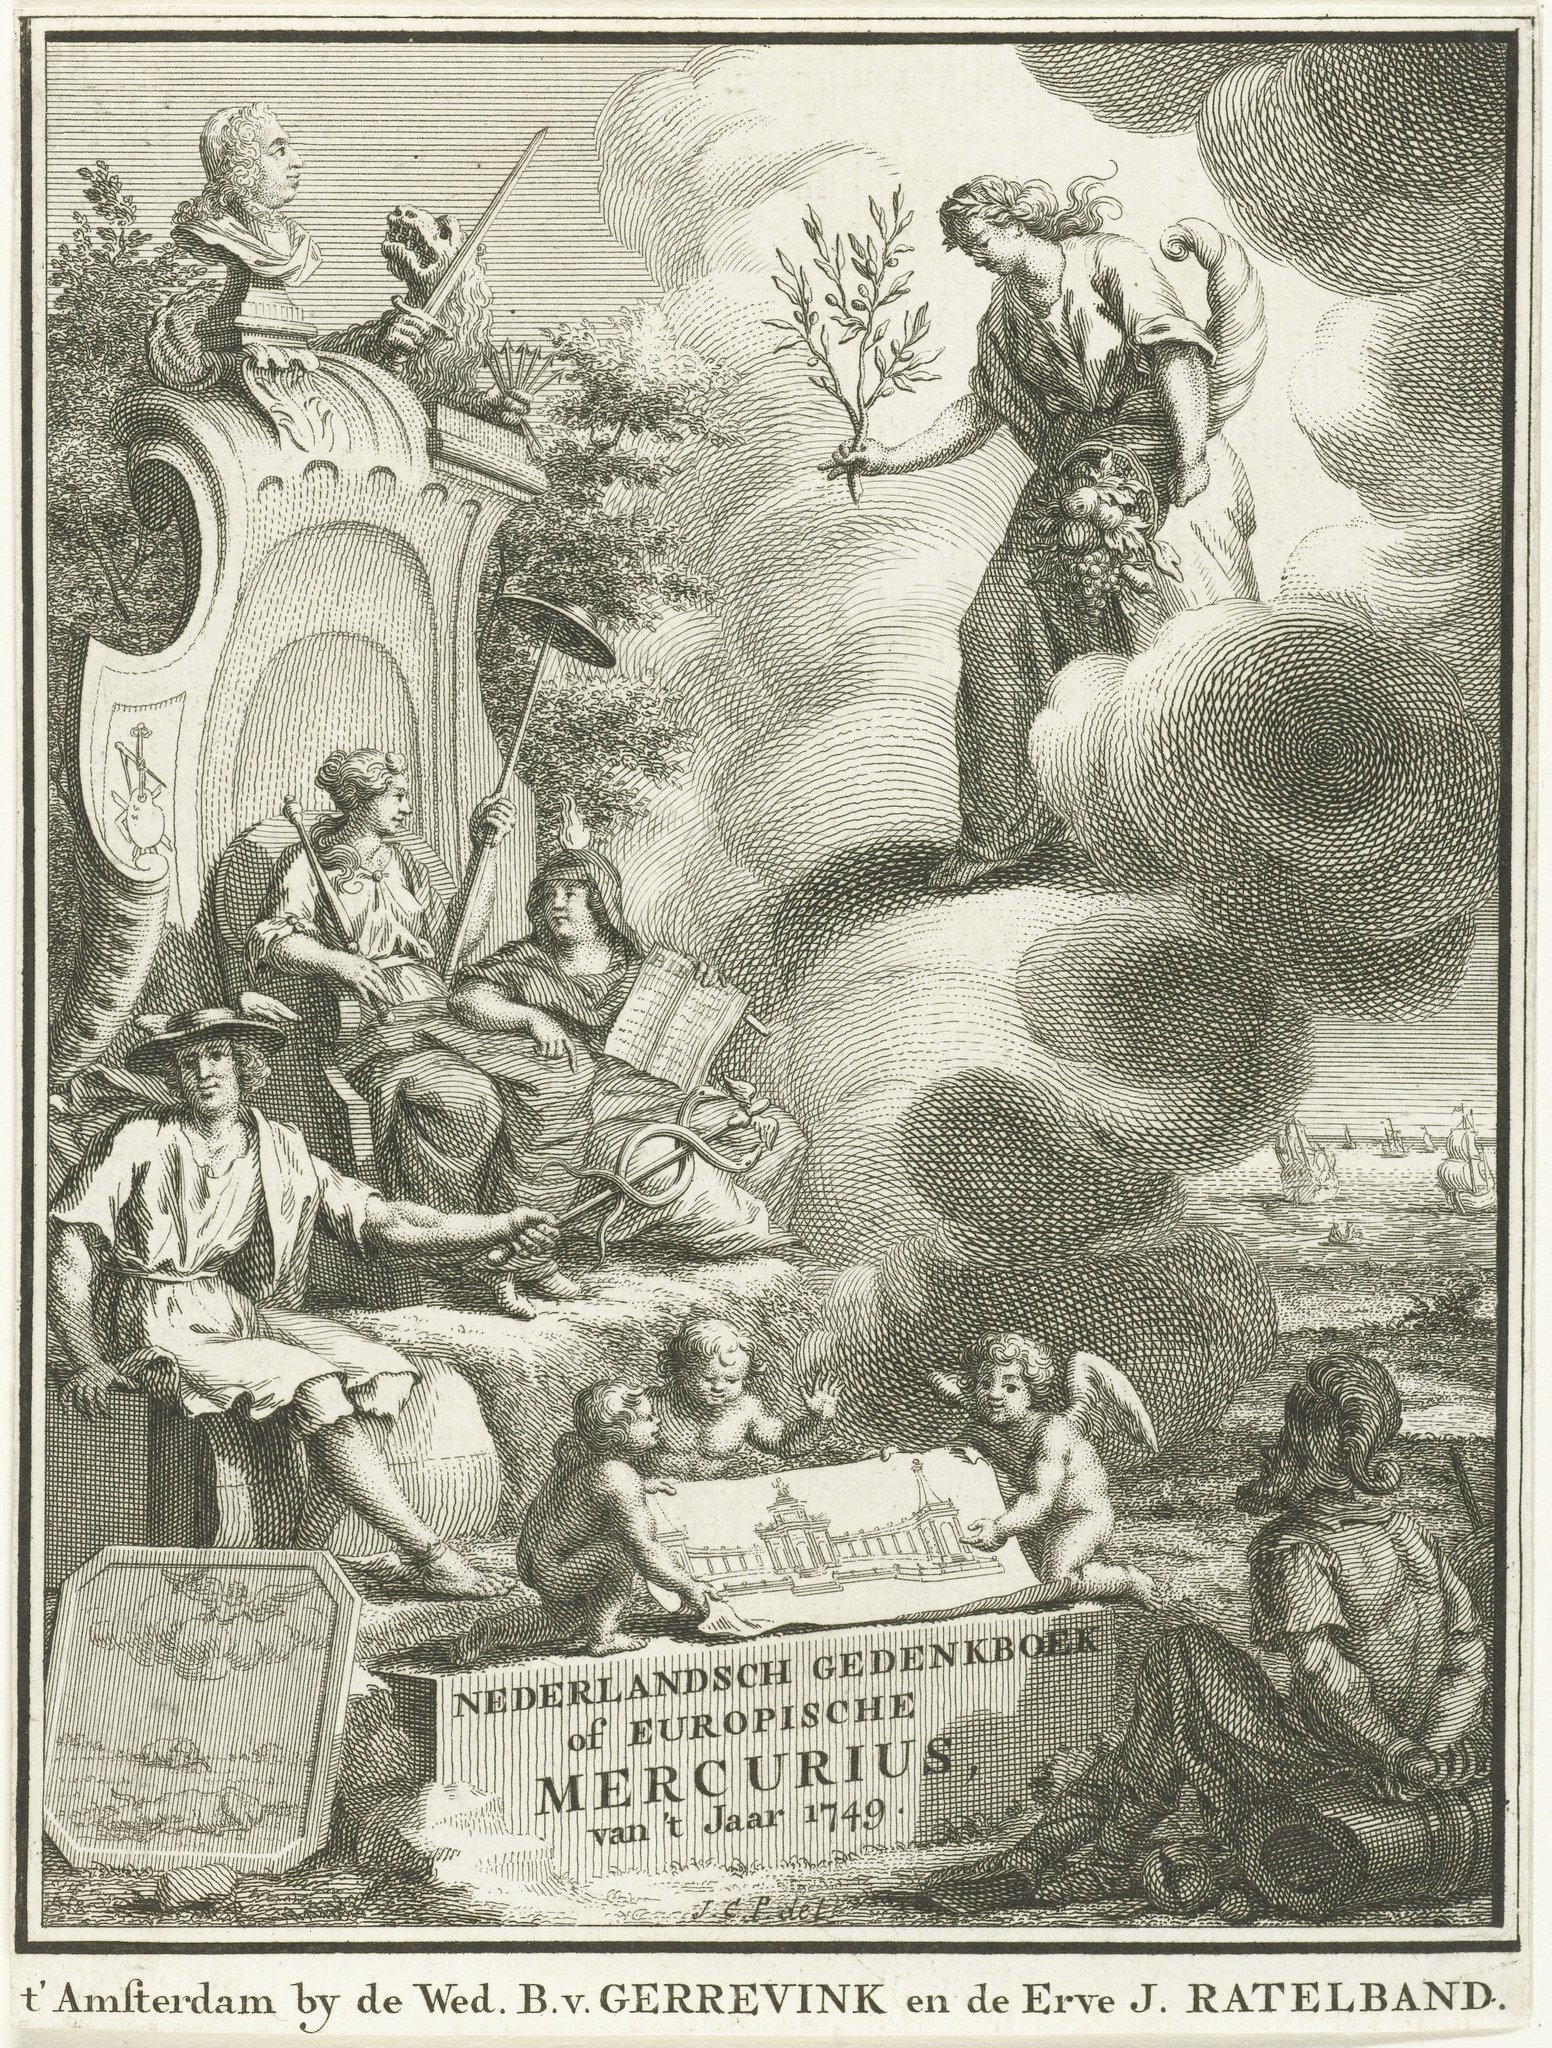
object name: titelblad, titelpagina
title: Titelpagina voor de Europische Mercurius van 1749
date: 1749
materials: paper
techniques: engraving, etching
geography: amsterdam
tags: symbols, allegories of peace, 'pax'; 'pace' (ripa), peace and prosperity, 'pax et abundantia'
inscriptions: collector's mark: Lugt 2228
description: Titelpagina voor het Nederlandsch Gedenkboek of Europische Mercurius, over het jaar 1749. Mercurius zit aan de voet van de troon van de Nederlandse vrijheid, in de wolken de Vrede met een hoorn van overvloed. Putti met een prent van het theater te Den Haag voor het vuurwerk bij de viering van de Vrede van Aken.